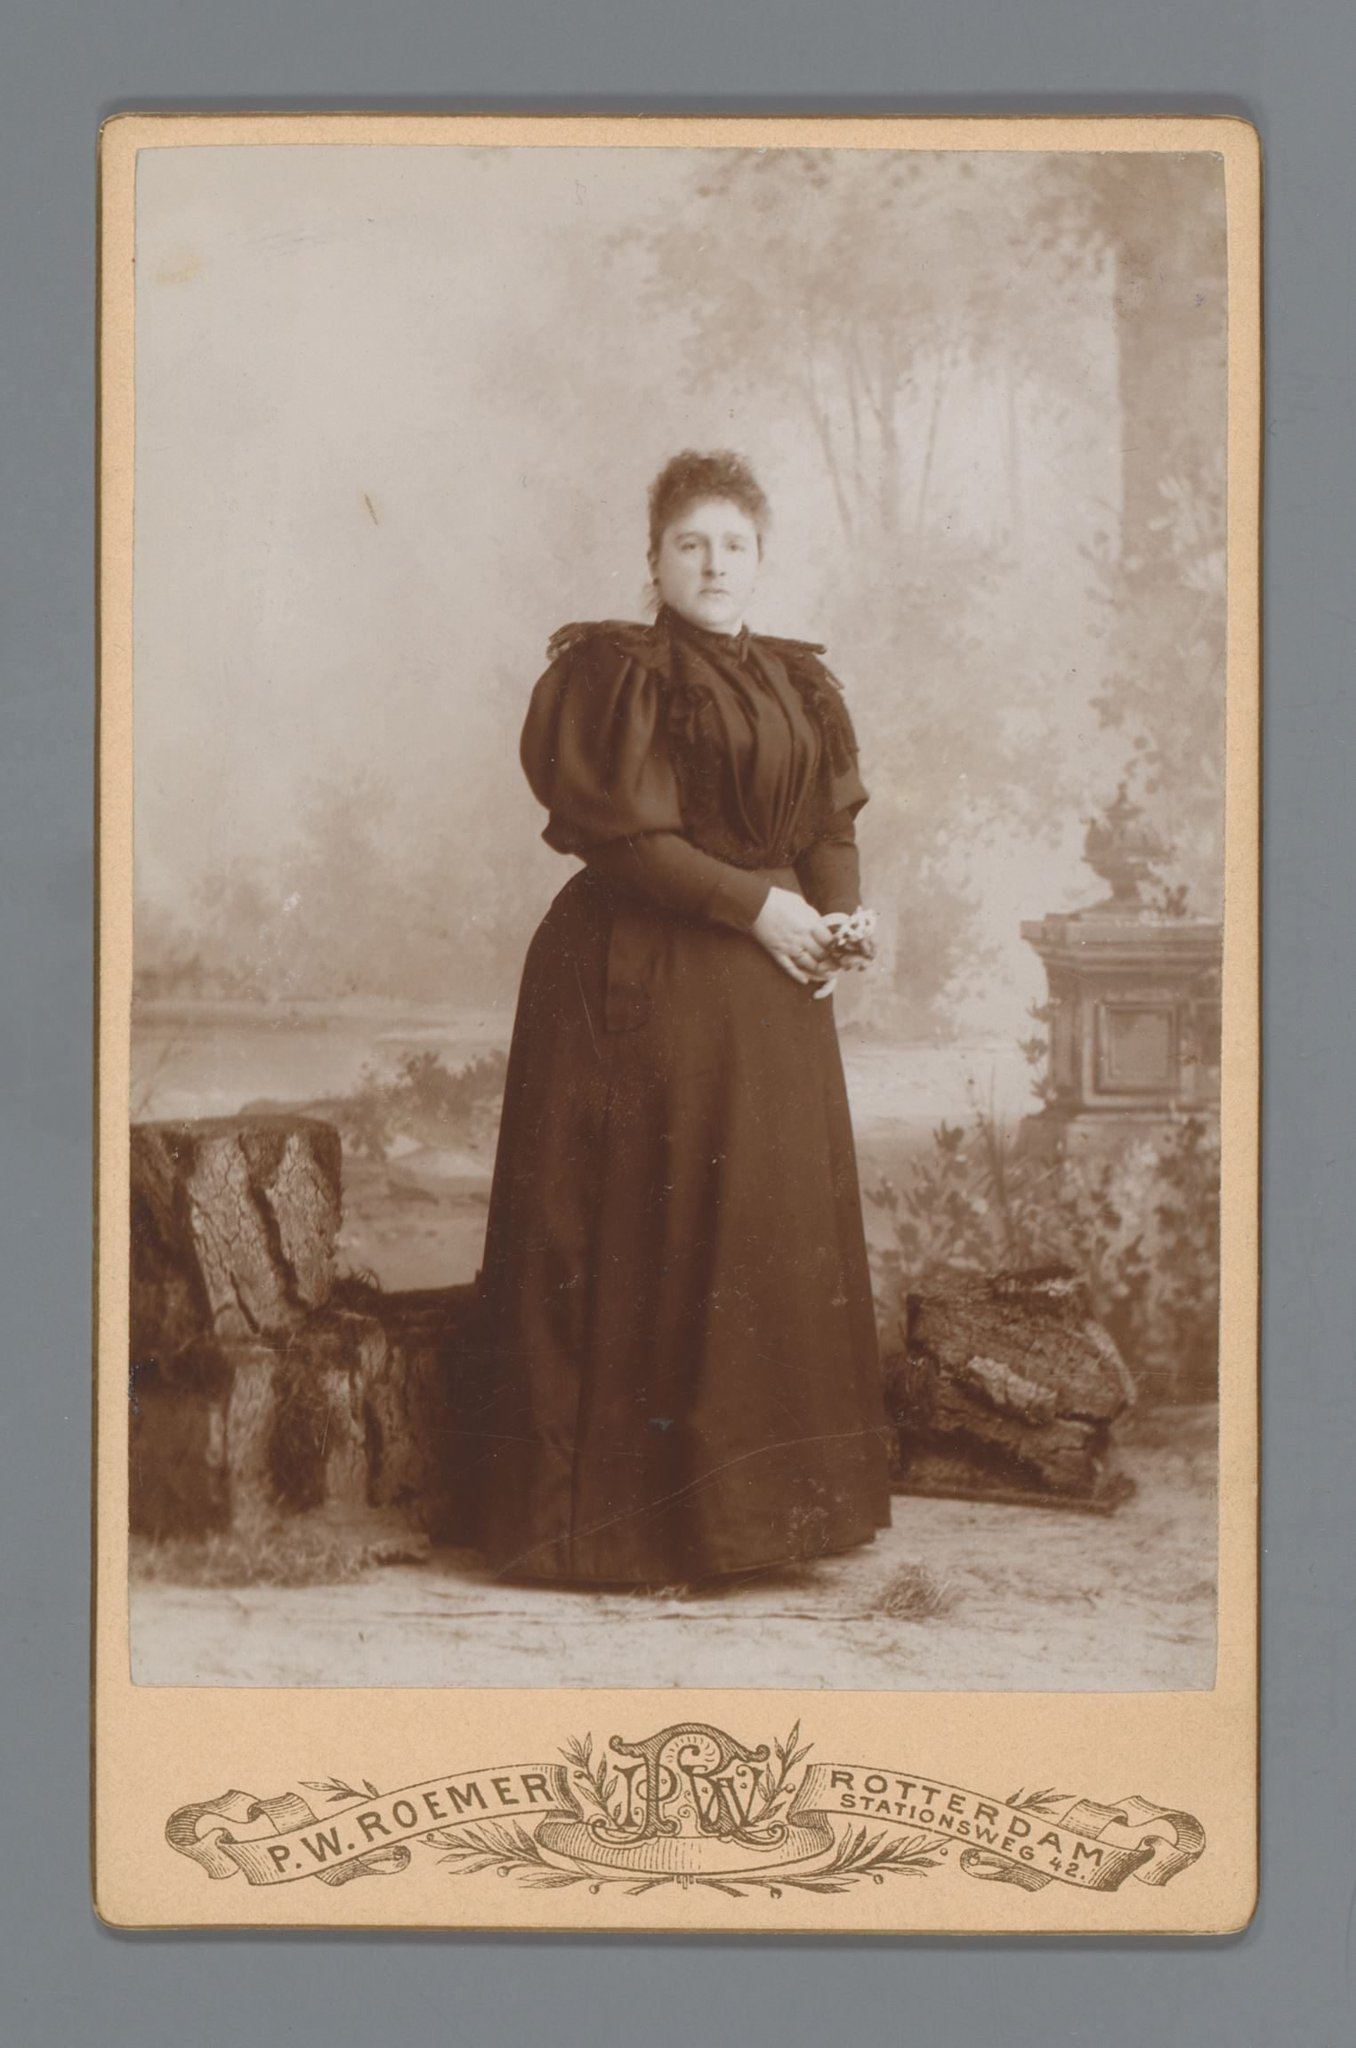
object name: cabinet photograph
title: Studioportret van een onbekende vrouw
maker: pieter wilhelmus roemer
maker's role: fotograaf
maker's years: 1838-1924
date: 1807-1894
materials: cardboard, photographic support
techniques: gelatin silver print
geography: rotterdam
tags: studio ~ photographer, adult woman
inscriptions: inscription: ‘Photographie Instantanée P.W. Roemer Rotterdam Stationsweg 42.’